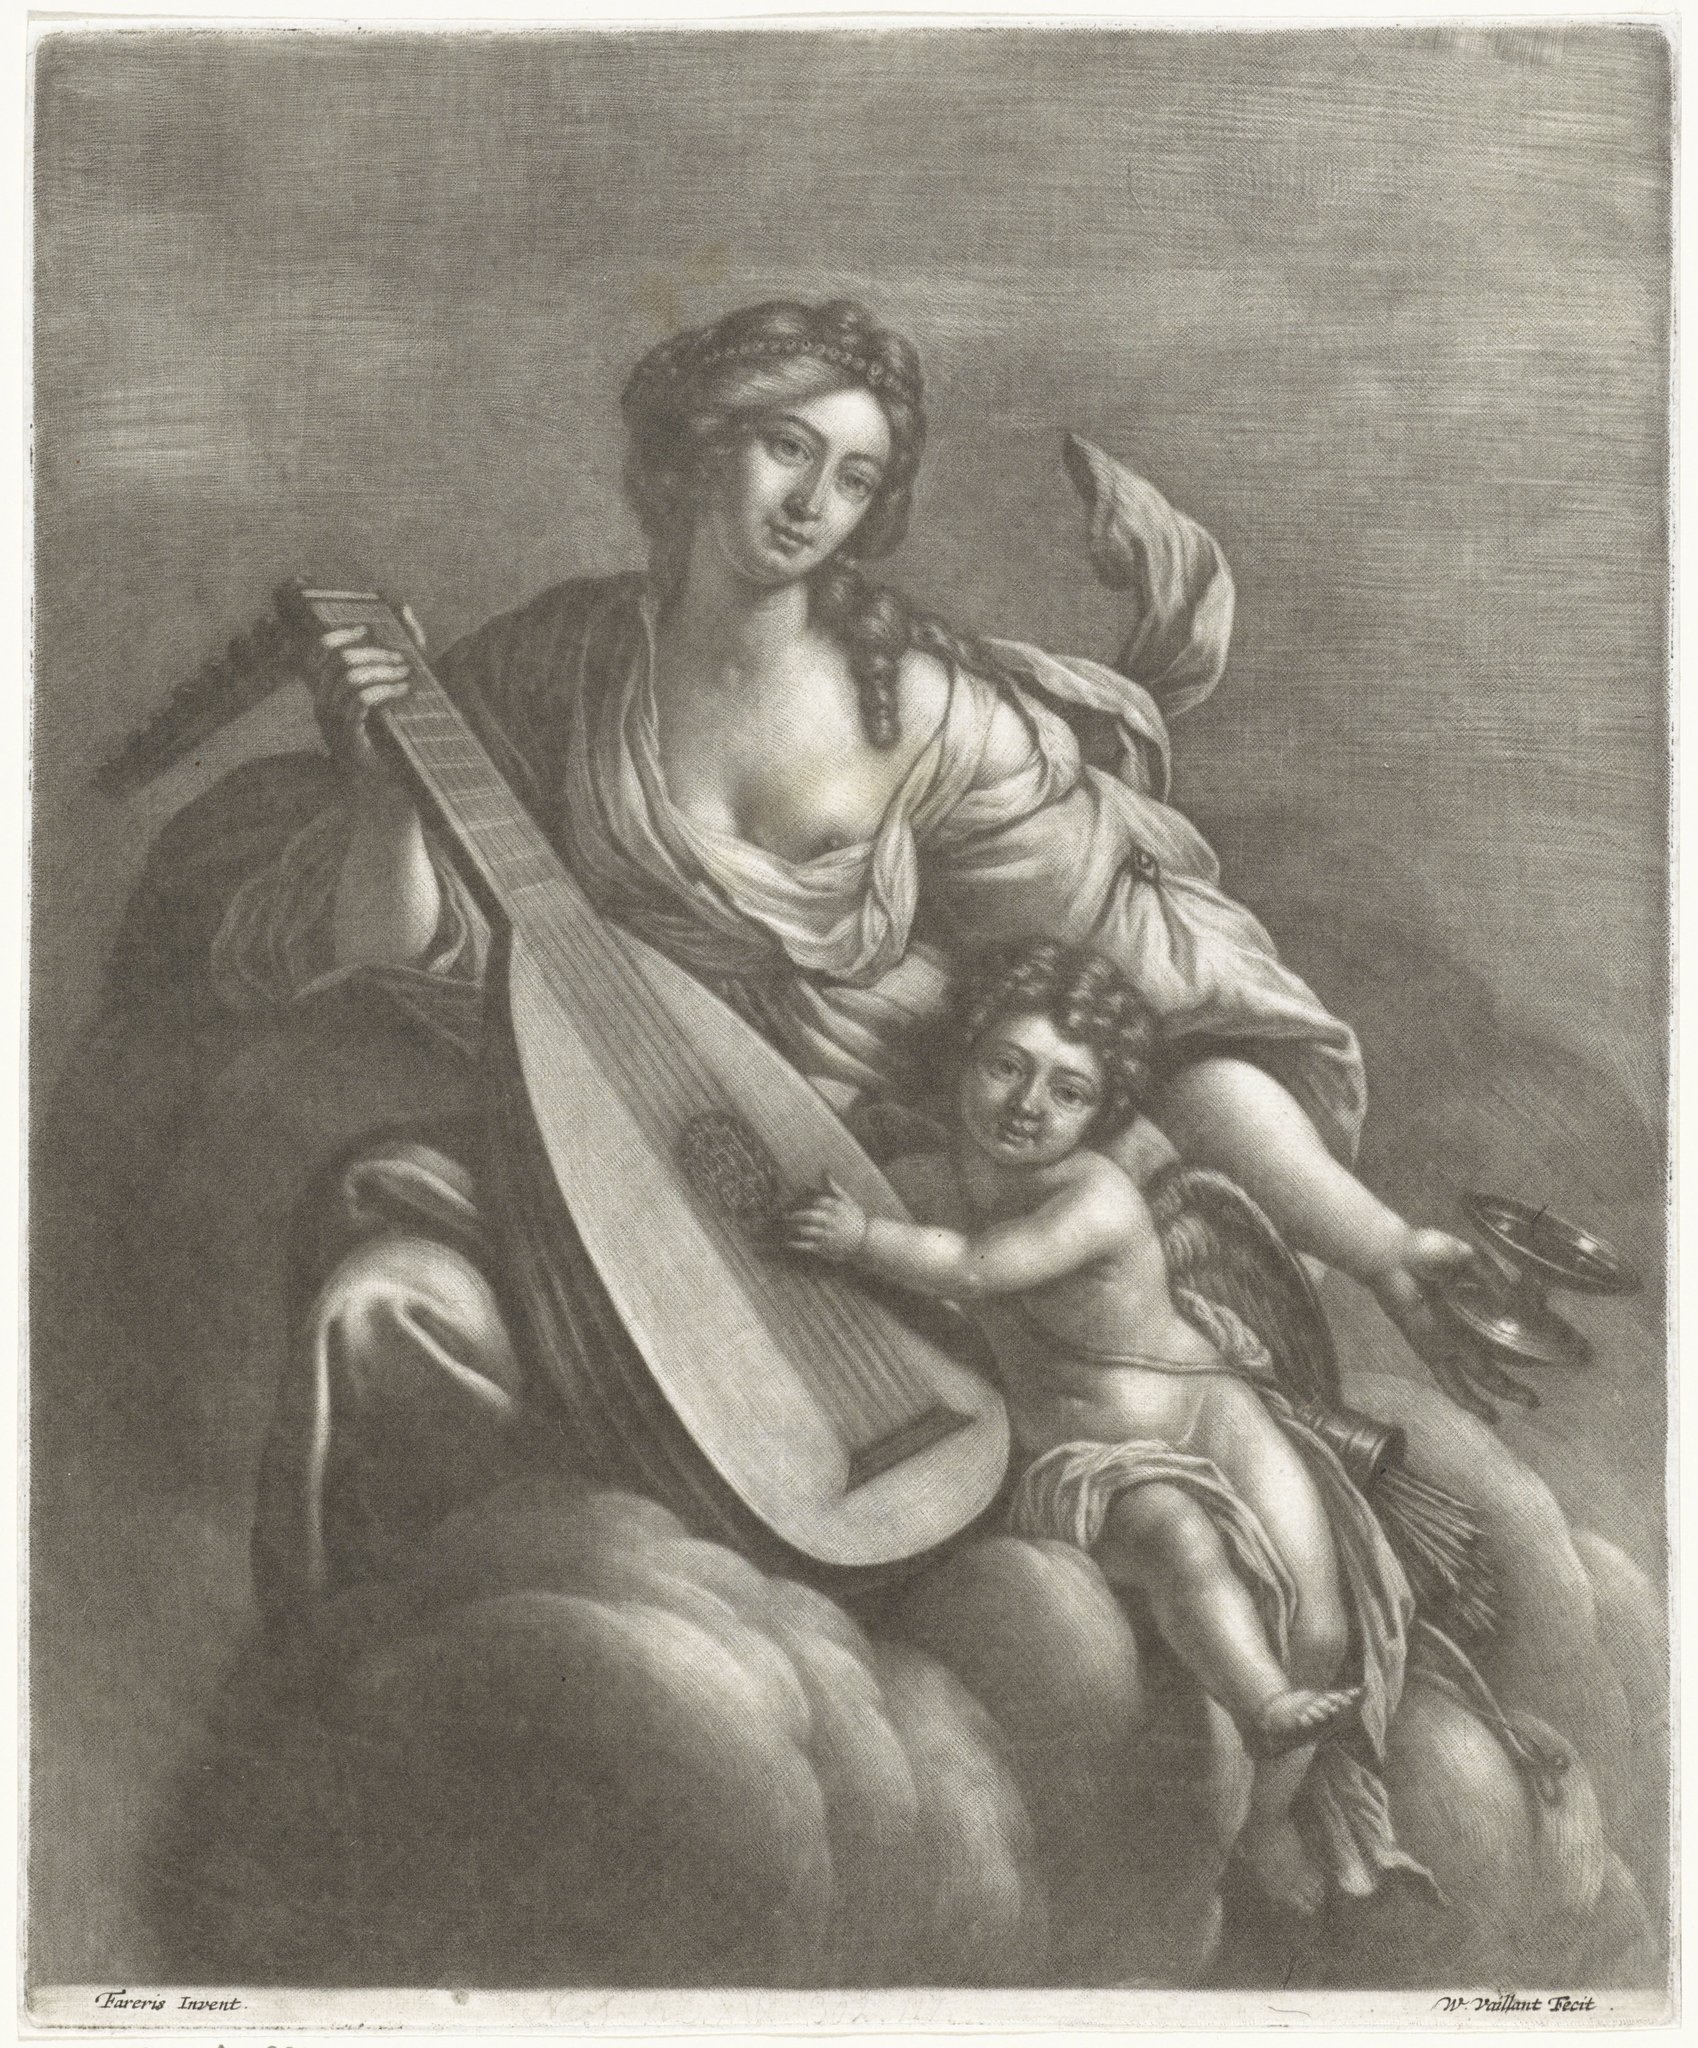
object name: print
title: Hebe en Amor op een wolk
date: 1658-1677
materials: paper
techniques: mezzotint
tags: (story of) hebe (juventas), (story of) cupid, amor (eros), drinking-vessels, lute, and special forms of lute, e.g.: theorbo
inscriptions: collector's mark: Lugt 2228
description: Hebe, de godin van de jeugd, zit met Amor op een wolk. Ze bespelen samen een luit.